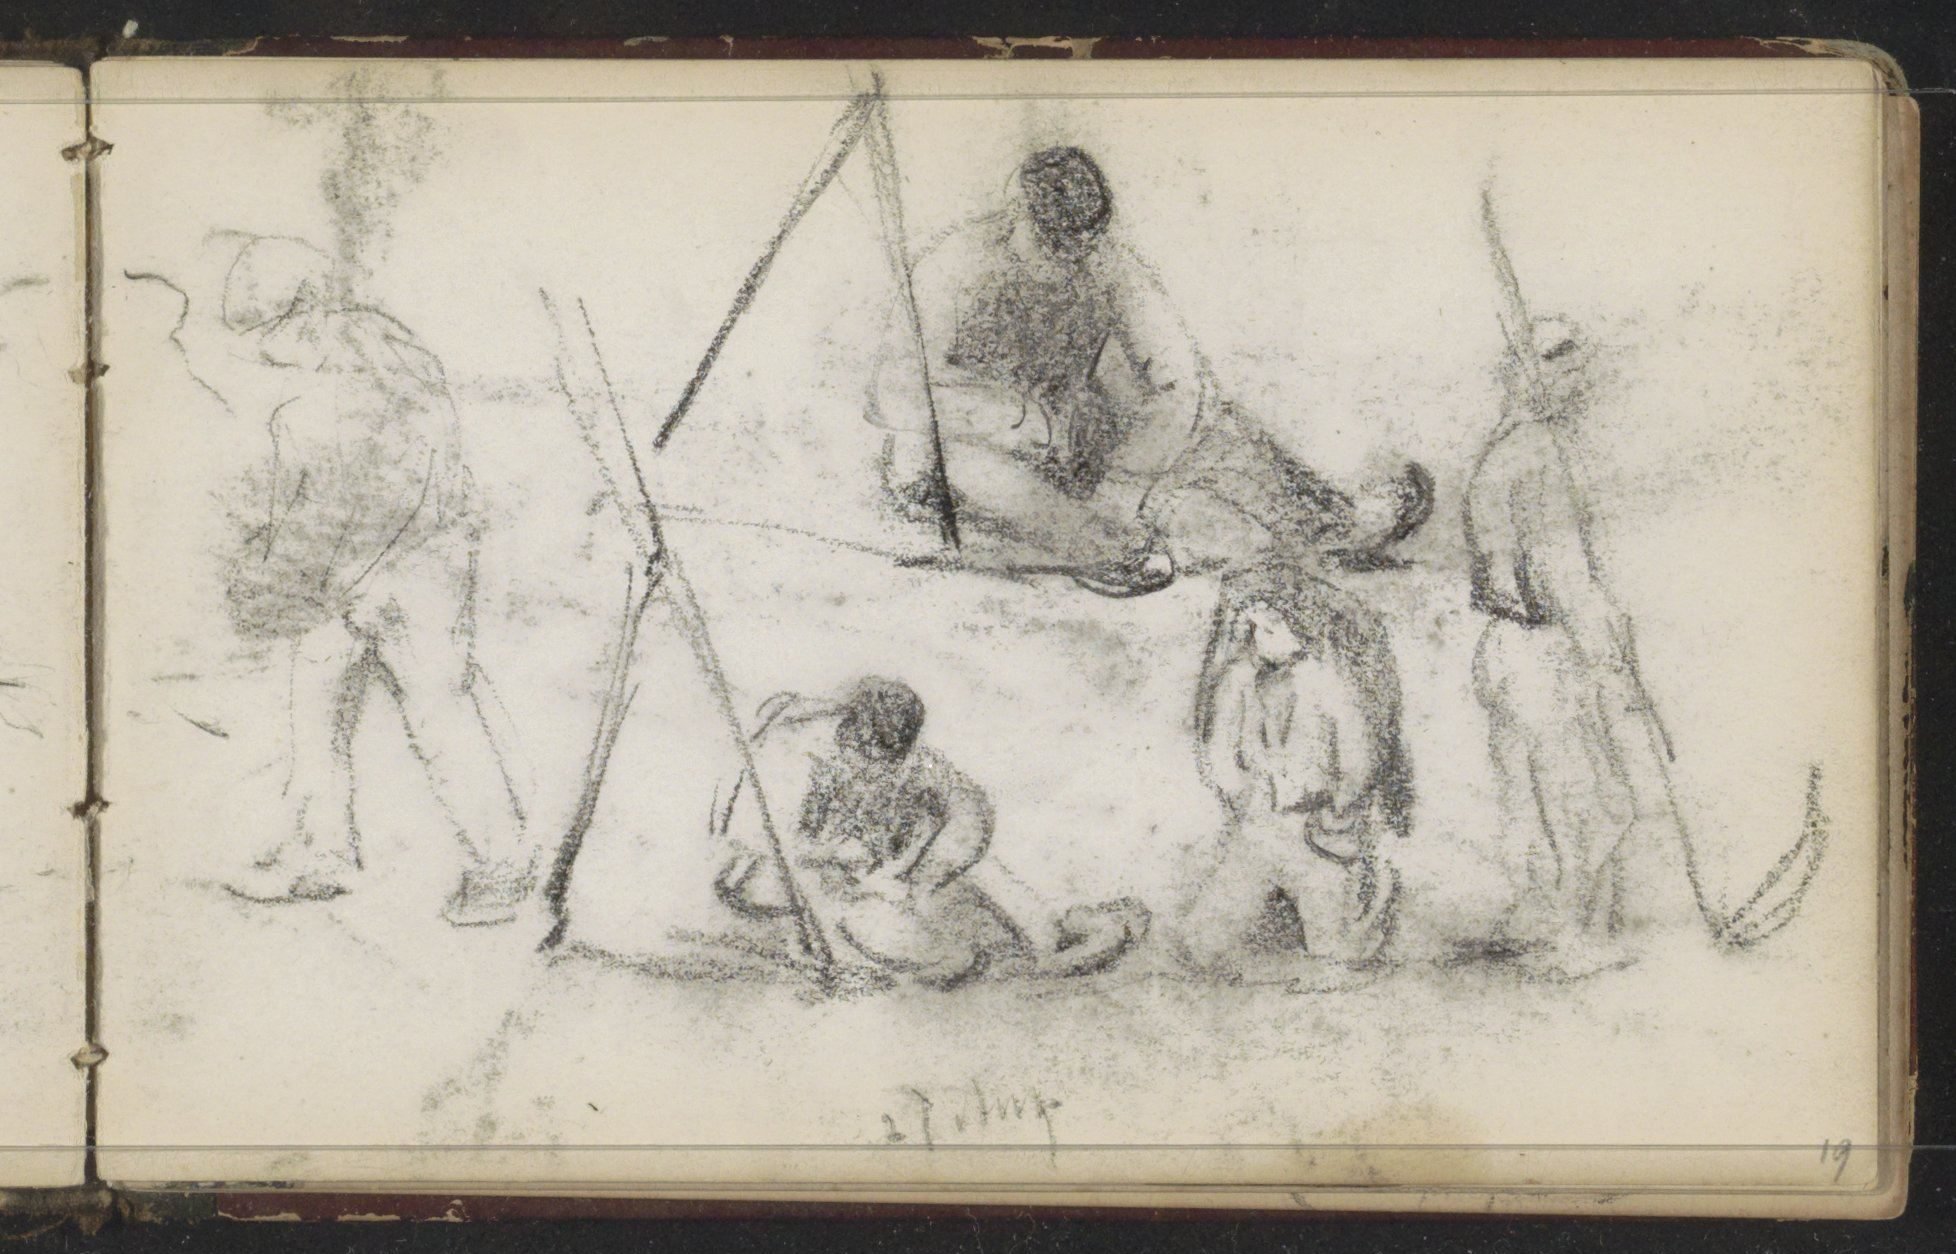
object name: sketchbook leaf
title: Arbeiders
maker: willem cornelis rip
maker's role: draughtsman, painter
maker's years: 1856-1922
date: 1808-1891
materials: chalk, paper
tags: agricultural implements: scythe, working class, labourers, sitting on the ground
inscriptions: date: ‘27 Aug’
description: Onder andere een man met een zeis en een man met een mand op de rug. Blad 19 recto uit een schetsboek met 28 bladen.